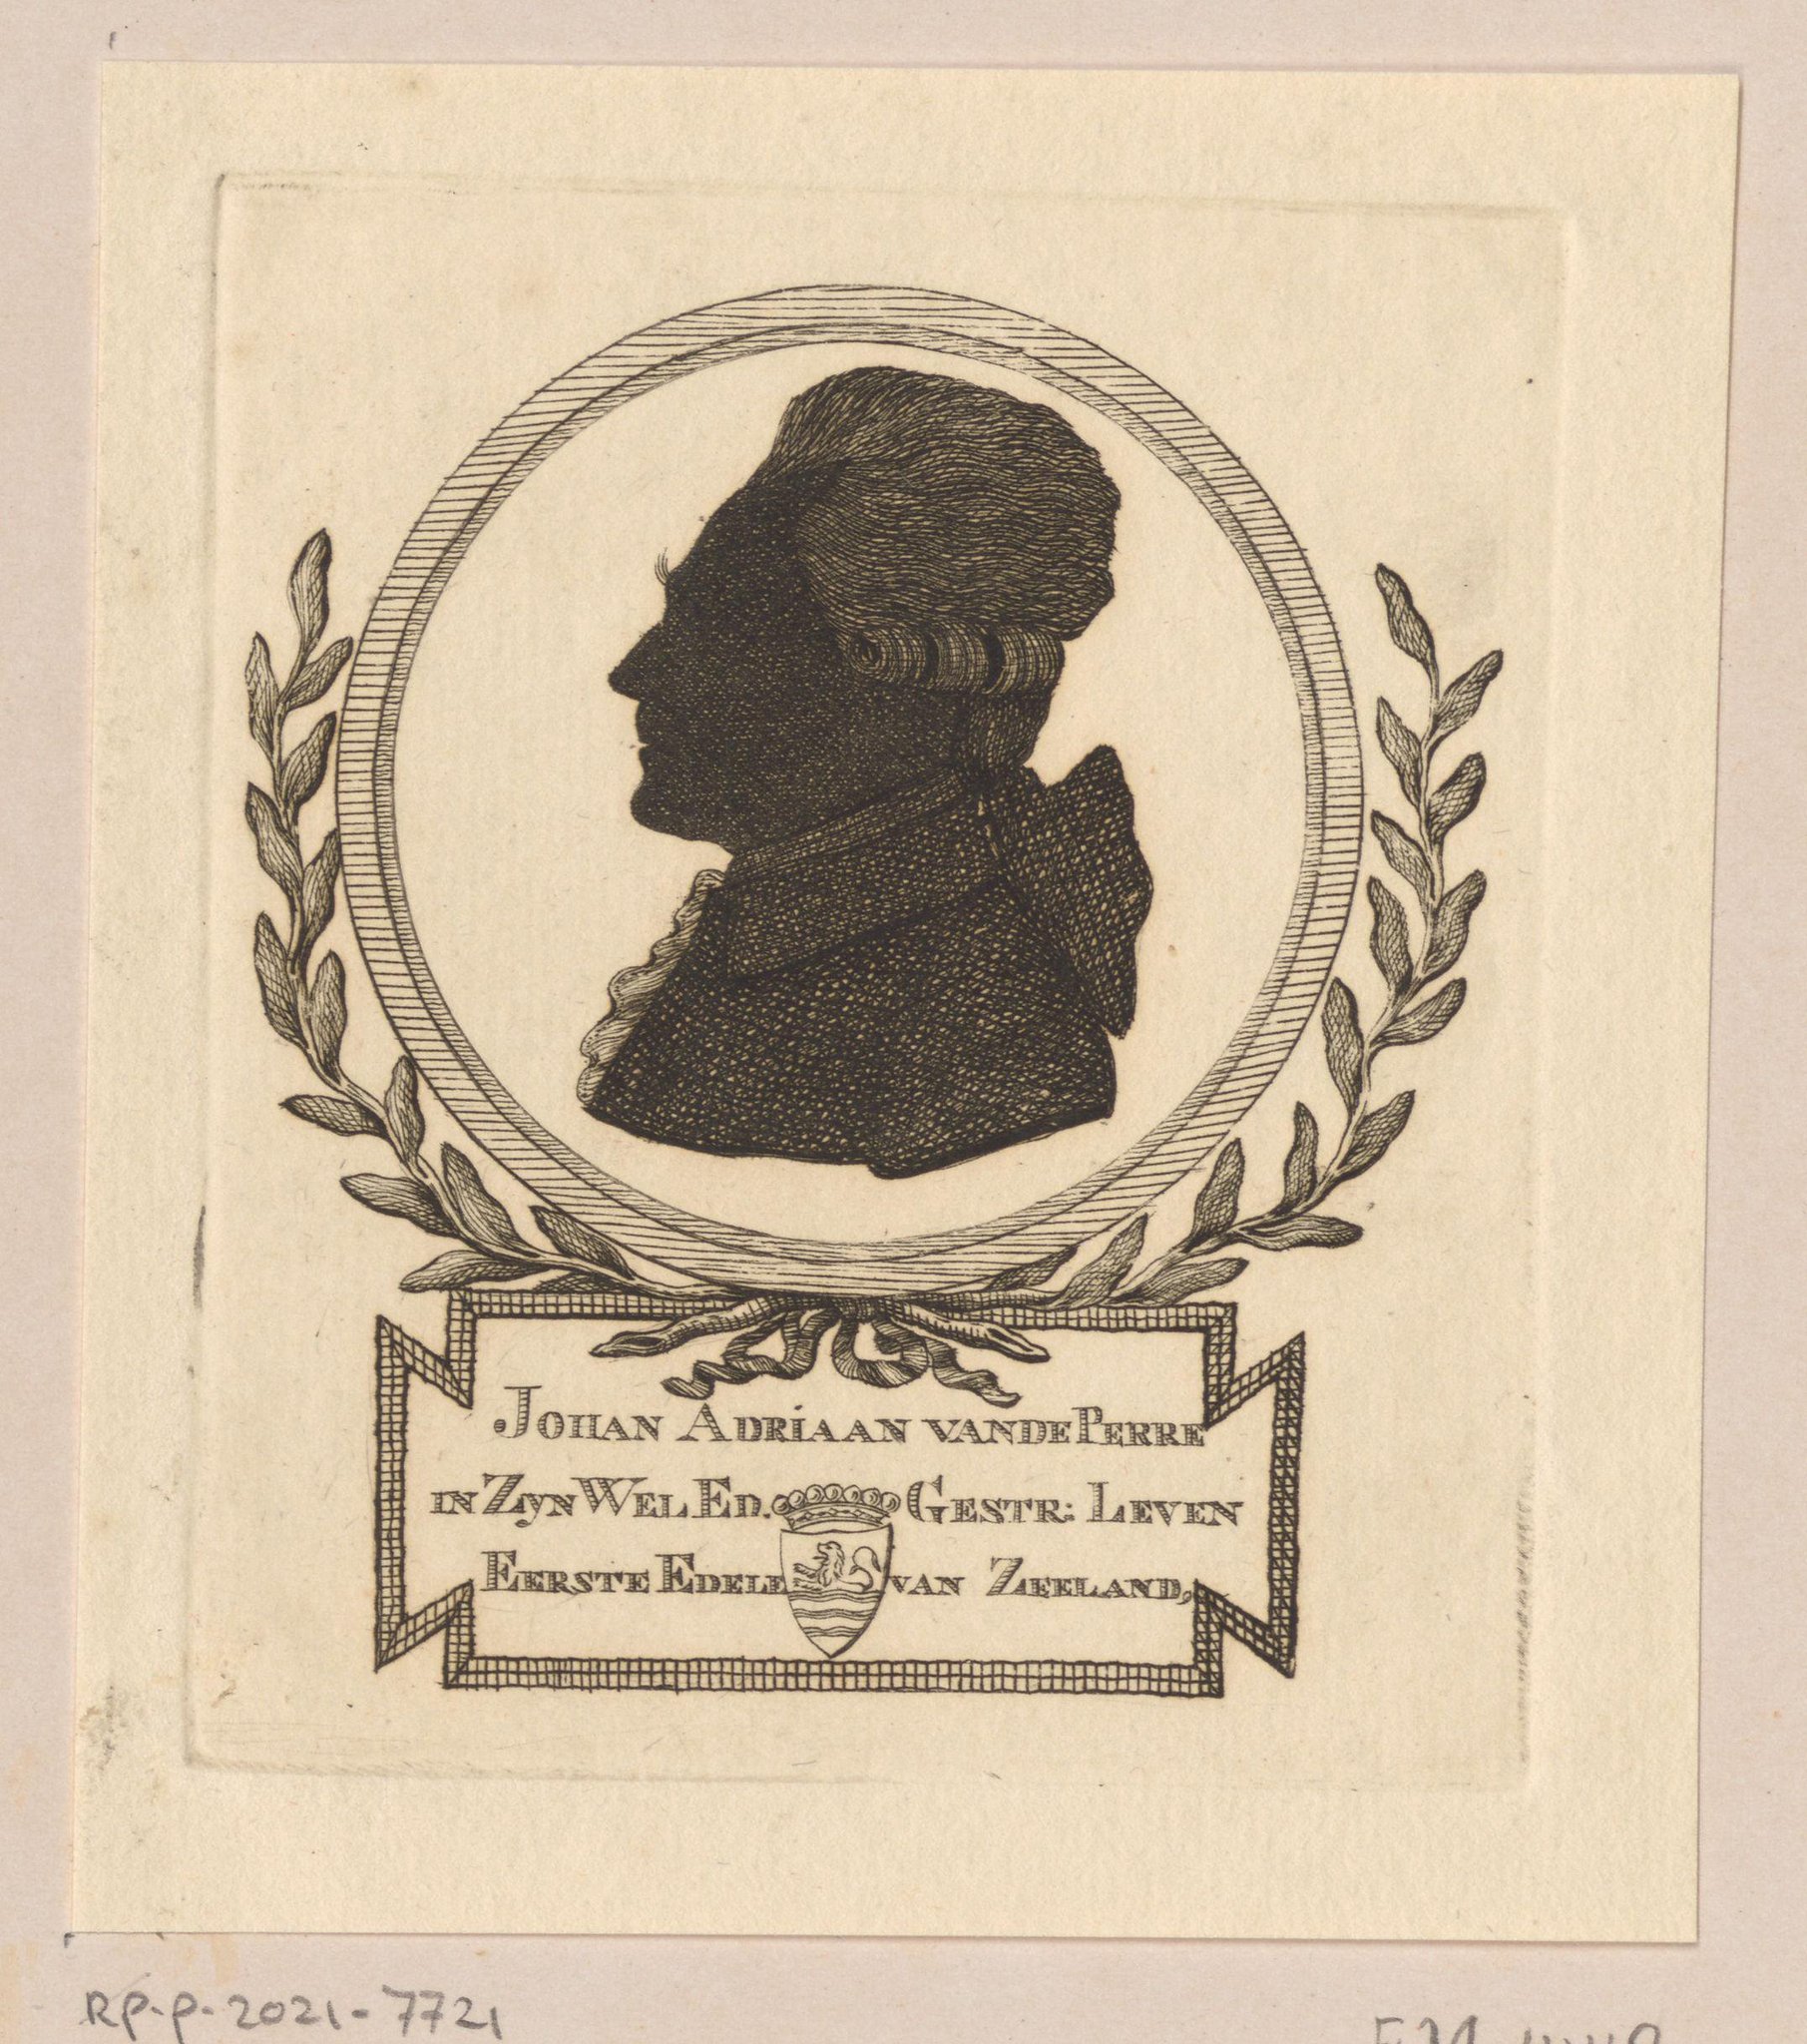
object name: print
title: Portret van Johan Adriaan van de Perre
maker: Anonymous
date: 1750-1799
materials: paper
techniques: engraving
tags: adult man, historical persons